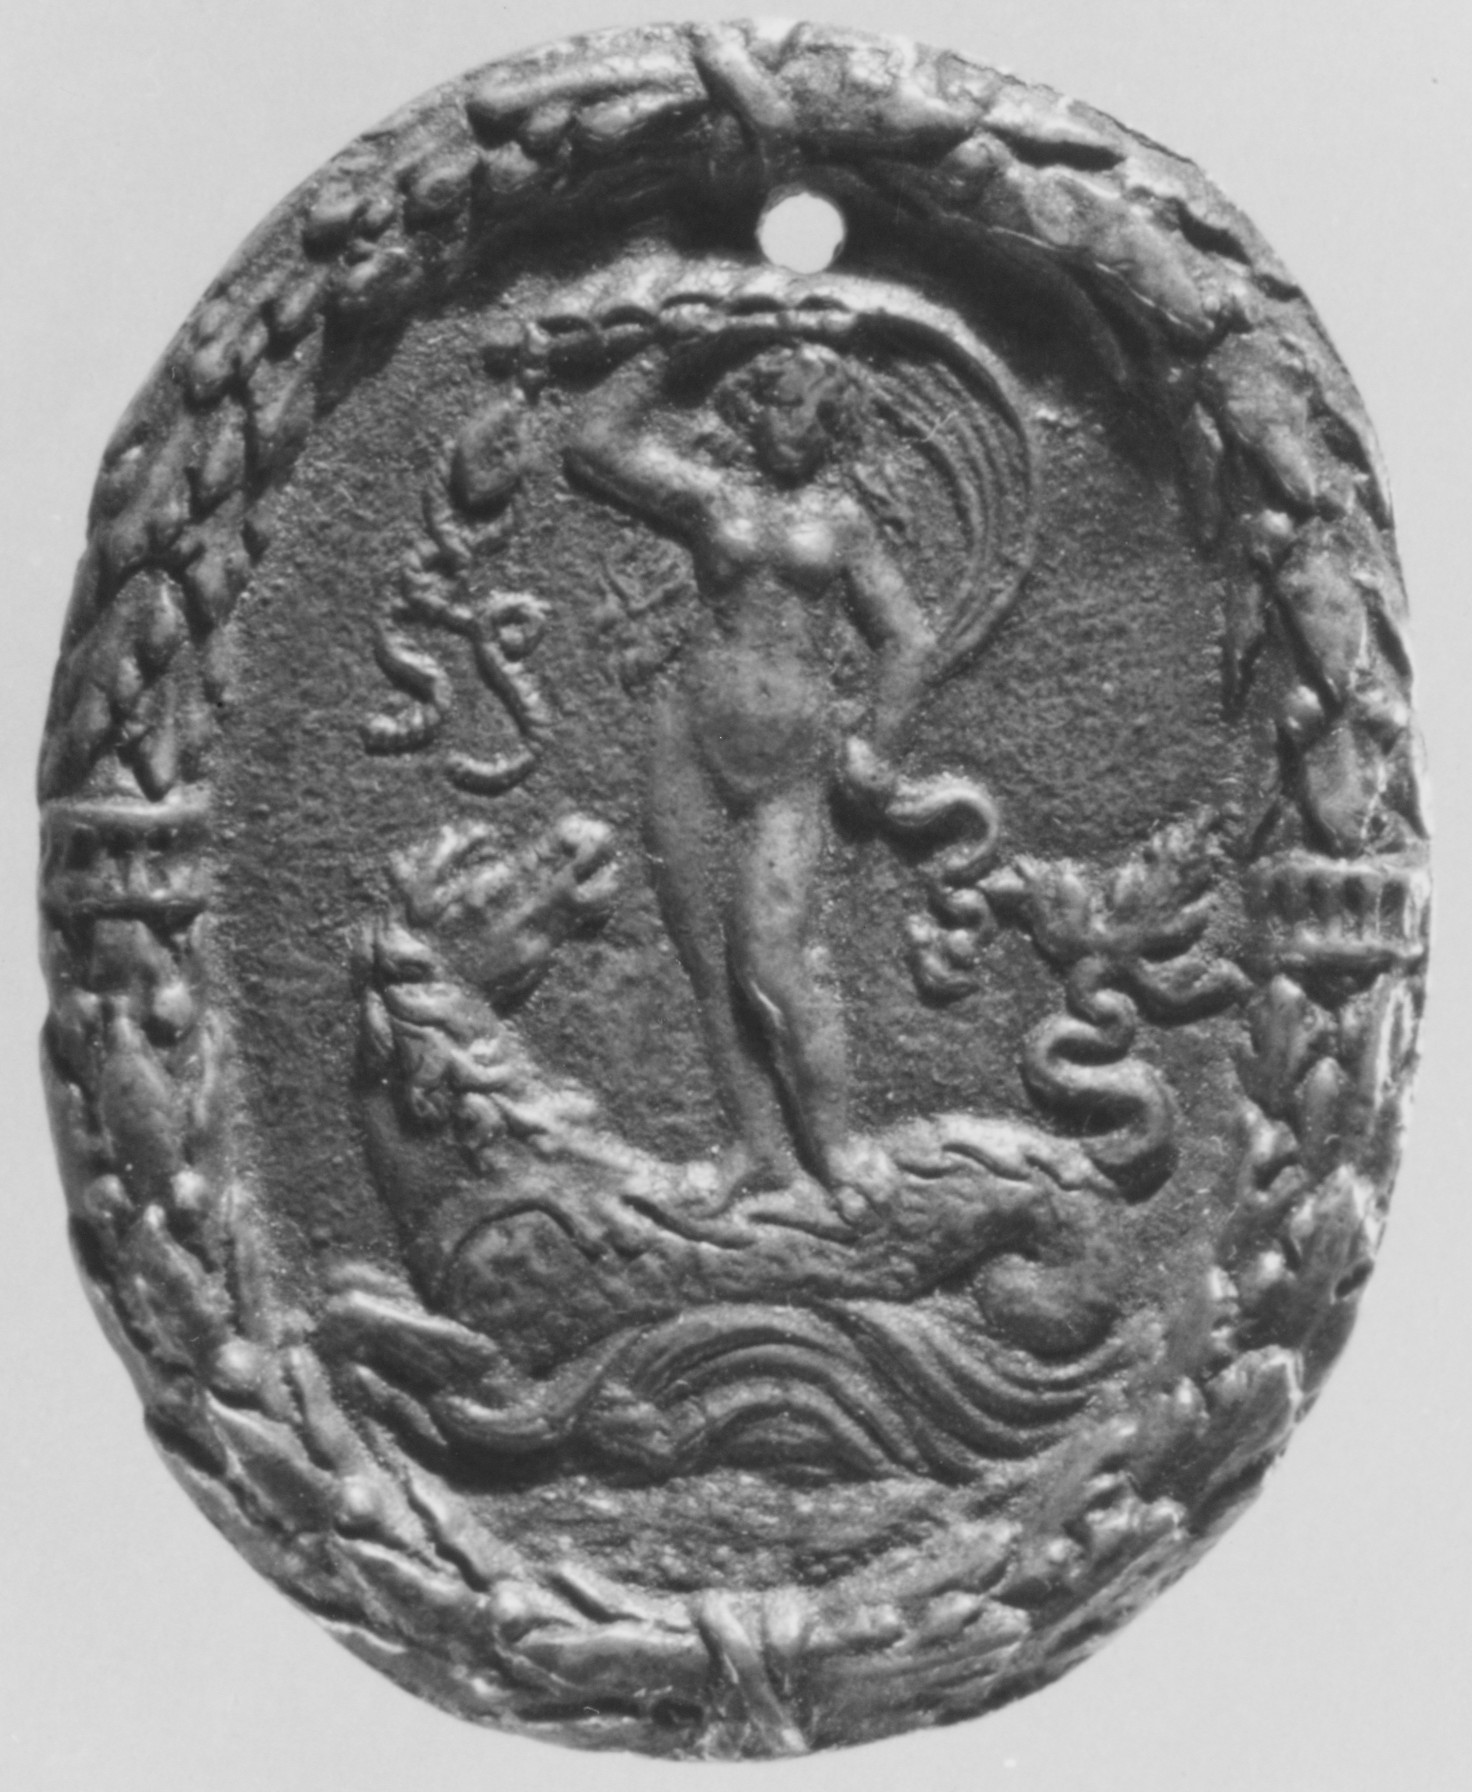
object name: plaquette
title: Fortune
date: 1401-1600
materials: bronze, lacquer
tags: female nudes,seahorses